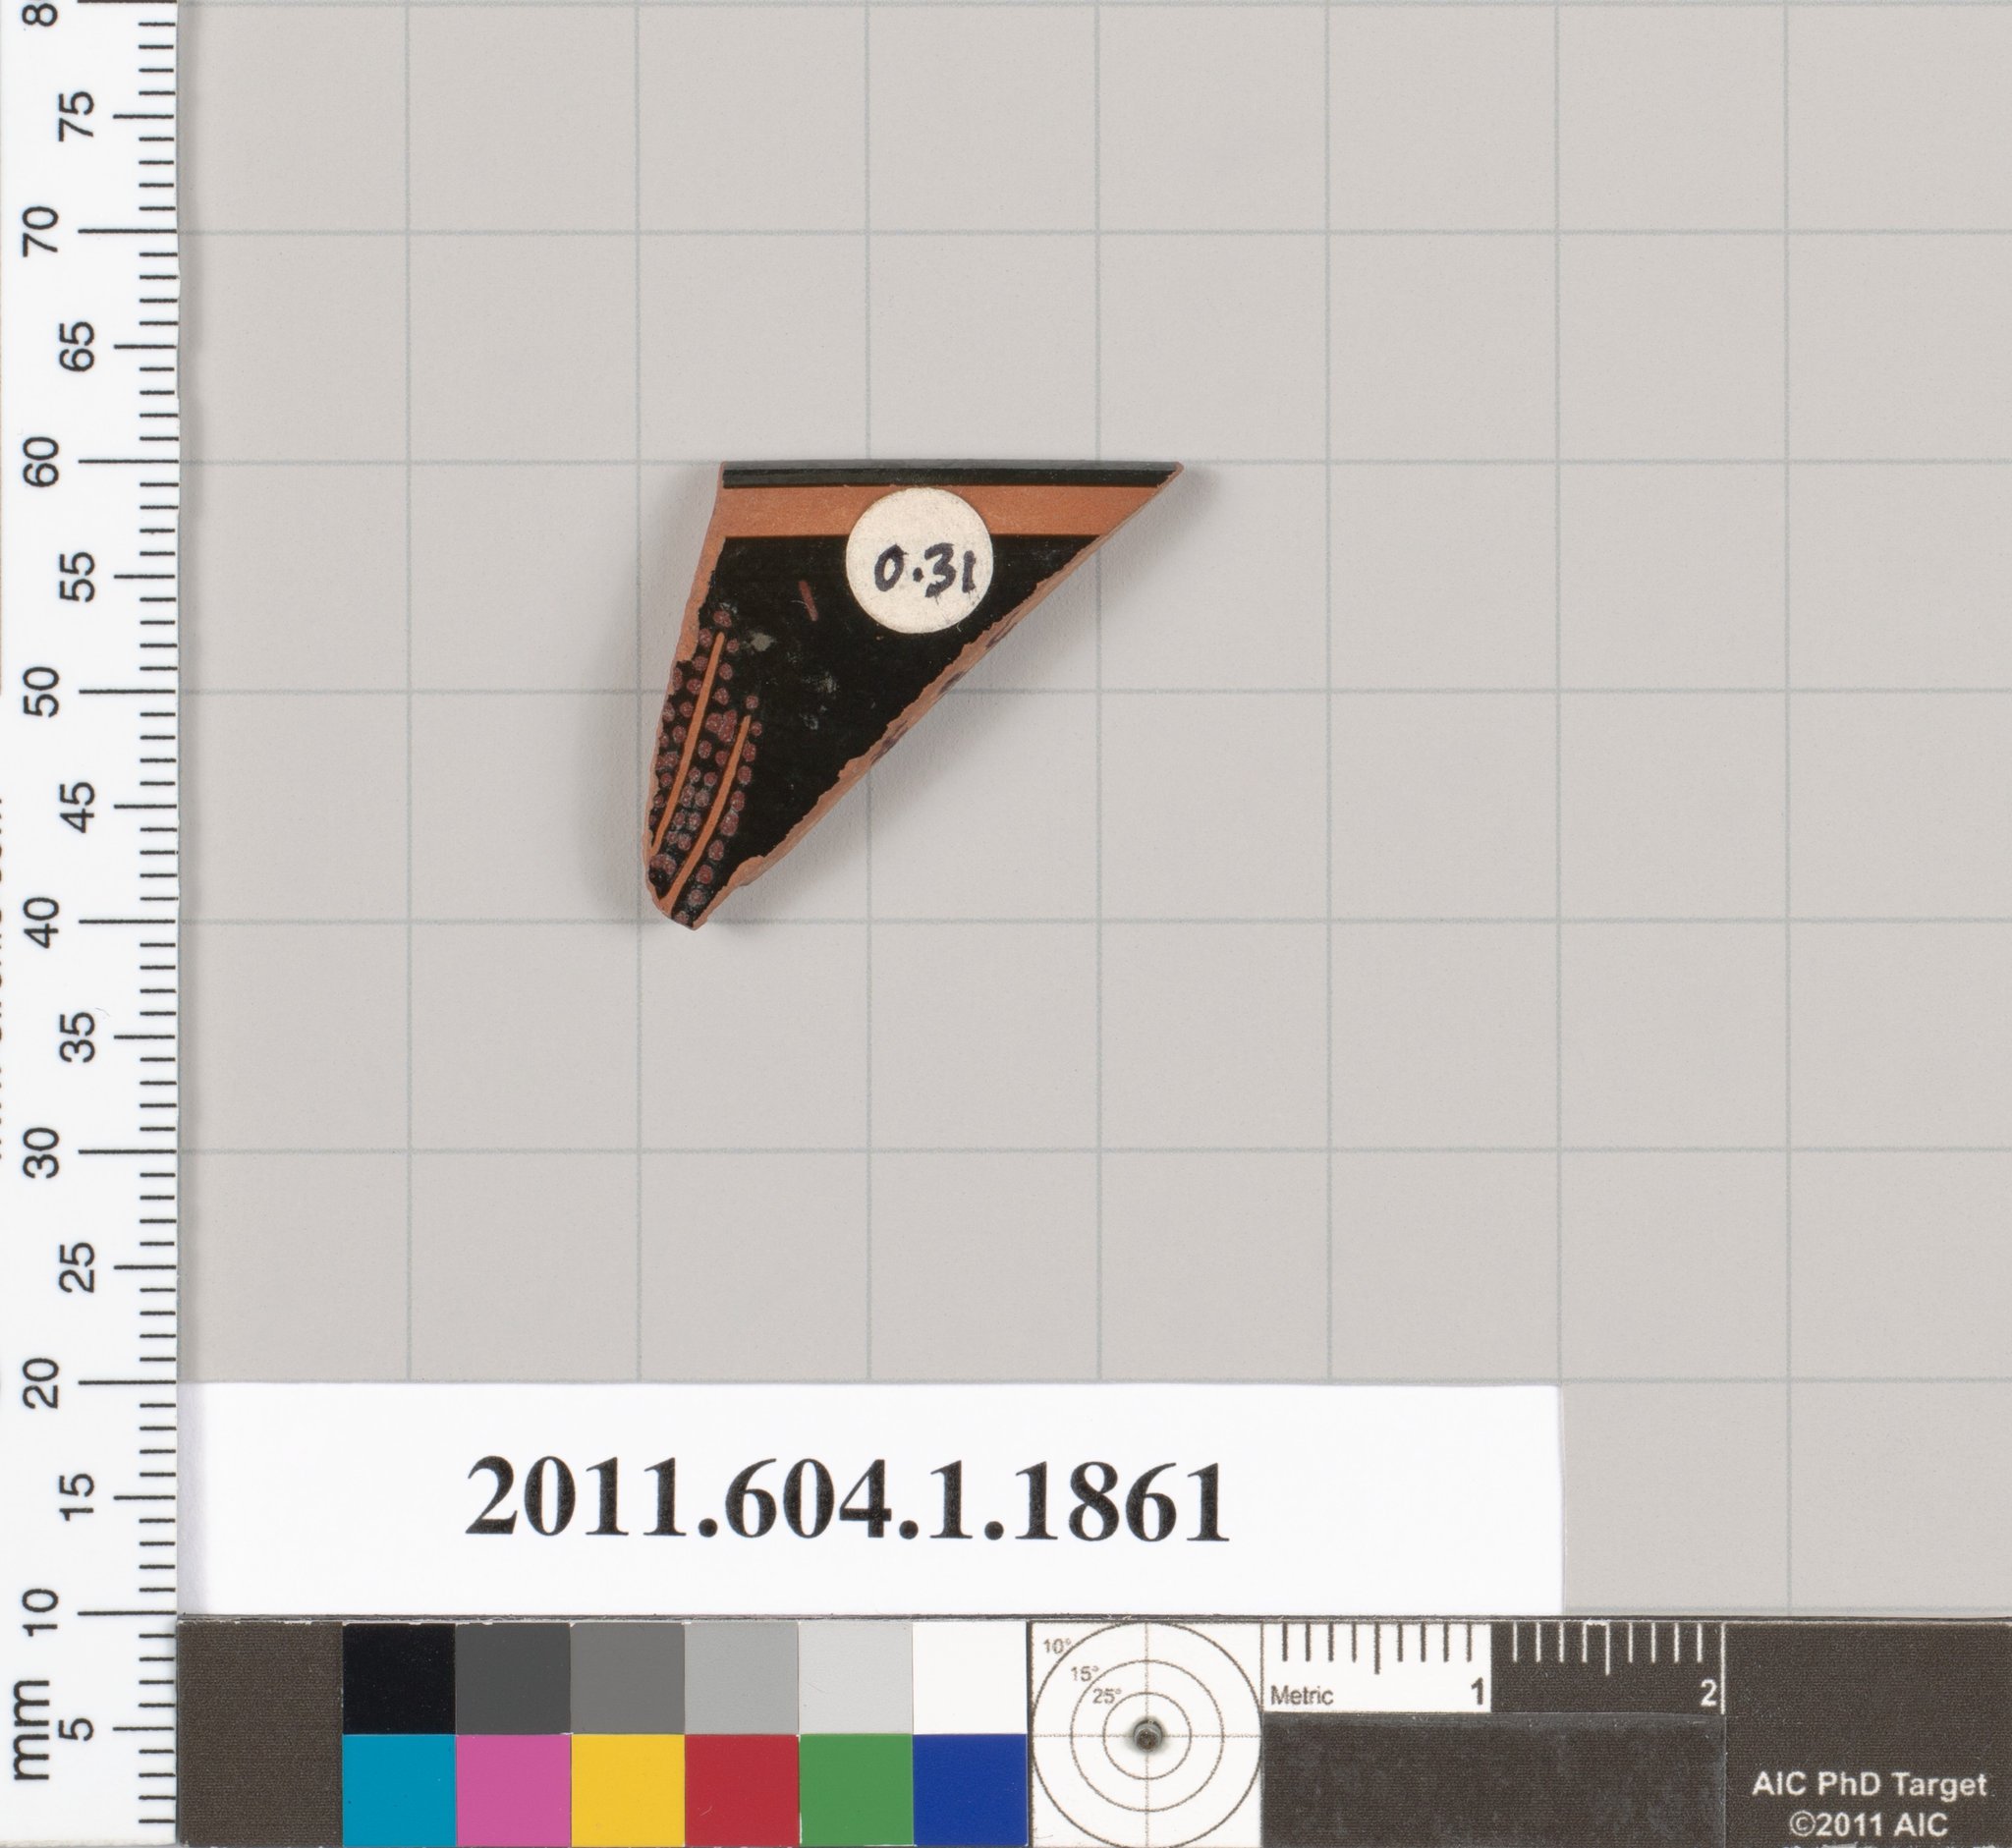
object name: kylix fragment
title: Terracotta rim fragment of a kylix (drinking cup)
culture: greek, attic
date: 500-480 BCE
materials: terracotta